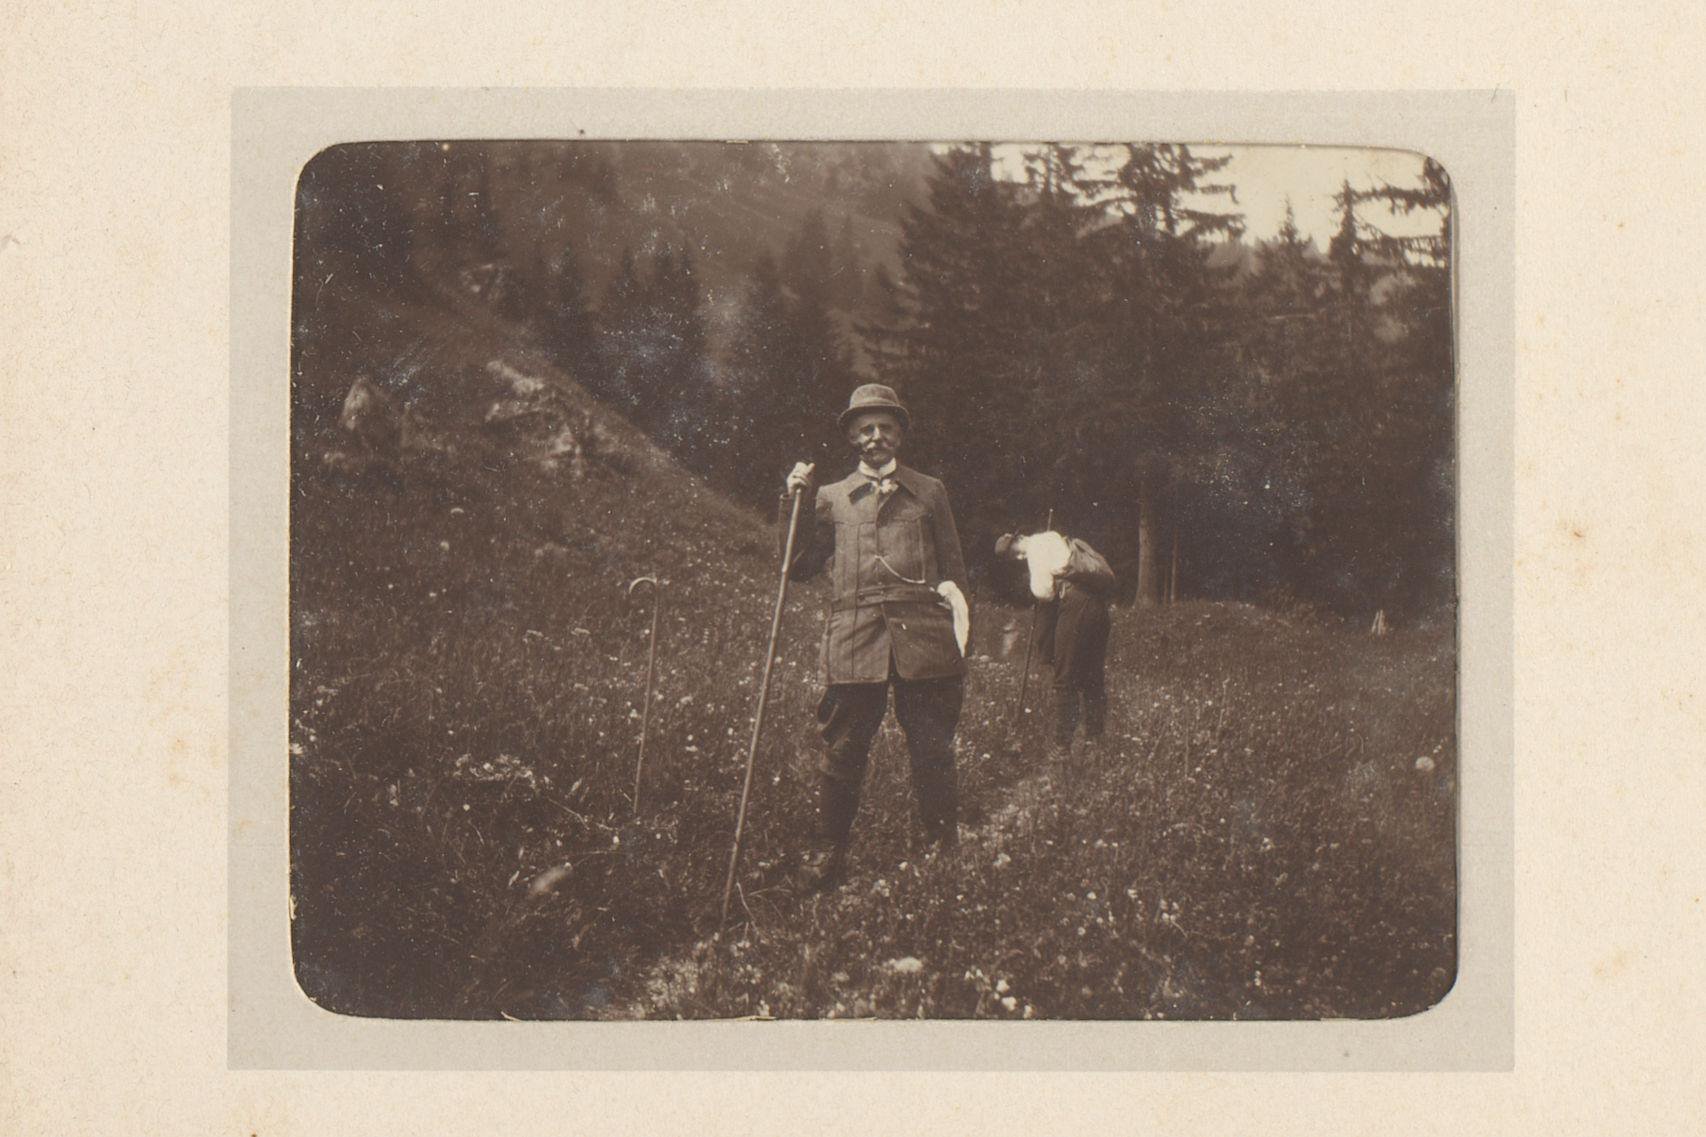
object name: photograph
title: Portret van een man met pijp, hoed en wandelstok op een wandelpad in de bergen, daarachter een andere man of vrouw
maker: liesbeth overhoff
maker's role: fotograaf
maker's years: 1895-1969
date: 1911-1912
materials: paper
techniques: gelatin silver print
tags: walking, hiking (recreation), walking-stick, staff, historical persons, pipe ~ tobacco, mountains